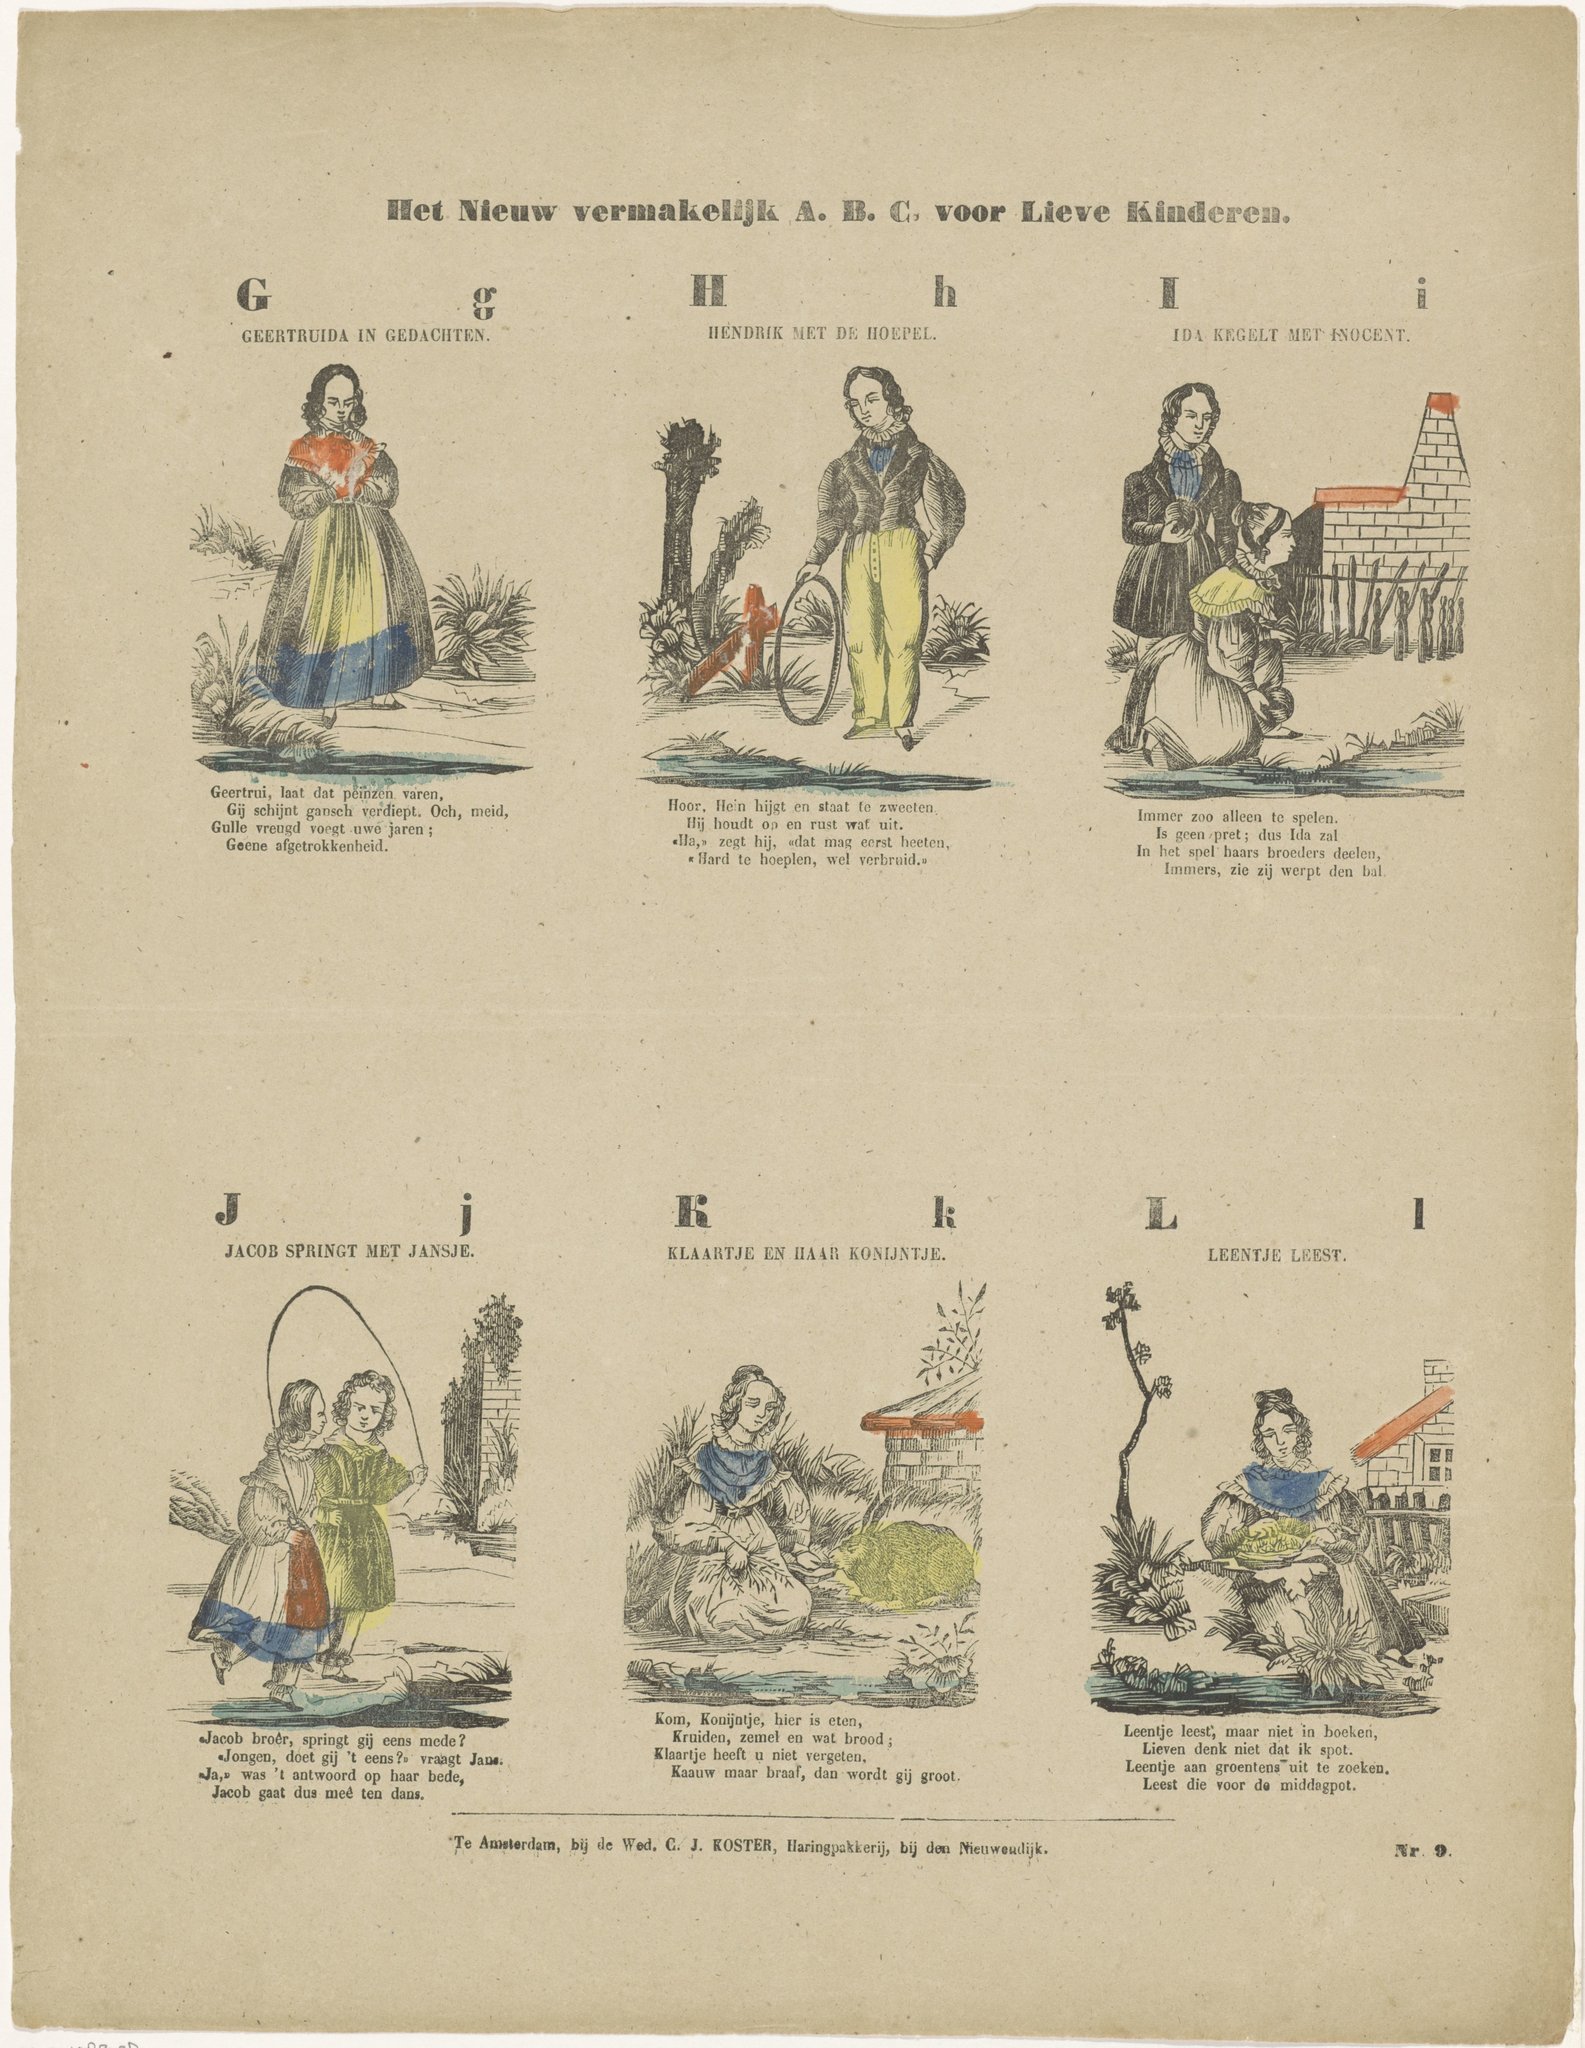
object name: print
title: Het nieuw vermakelijk A, B, C, voor lieve kinderen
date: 1825-1847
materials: paper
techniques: colour, letterpress printing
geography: amsterdam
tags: children's games and plays, letters, alphabet, script, child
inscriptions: collector's mark: Lugt 2760, collector's mark: Lugt 2228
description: Blad met 6 voorstellingen van de letters van het alfabet (G-L) geïllustreerd met spelende kinderen waarvan de namen met de betreffende letter beginnen. Onder elke afbeelding een vierregelig vers en boven elke afbeelding een titel. Genummerd rechtsonder: Nr. 9.